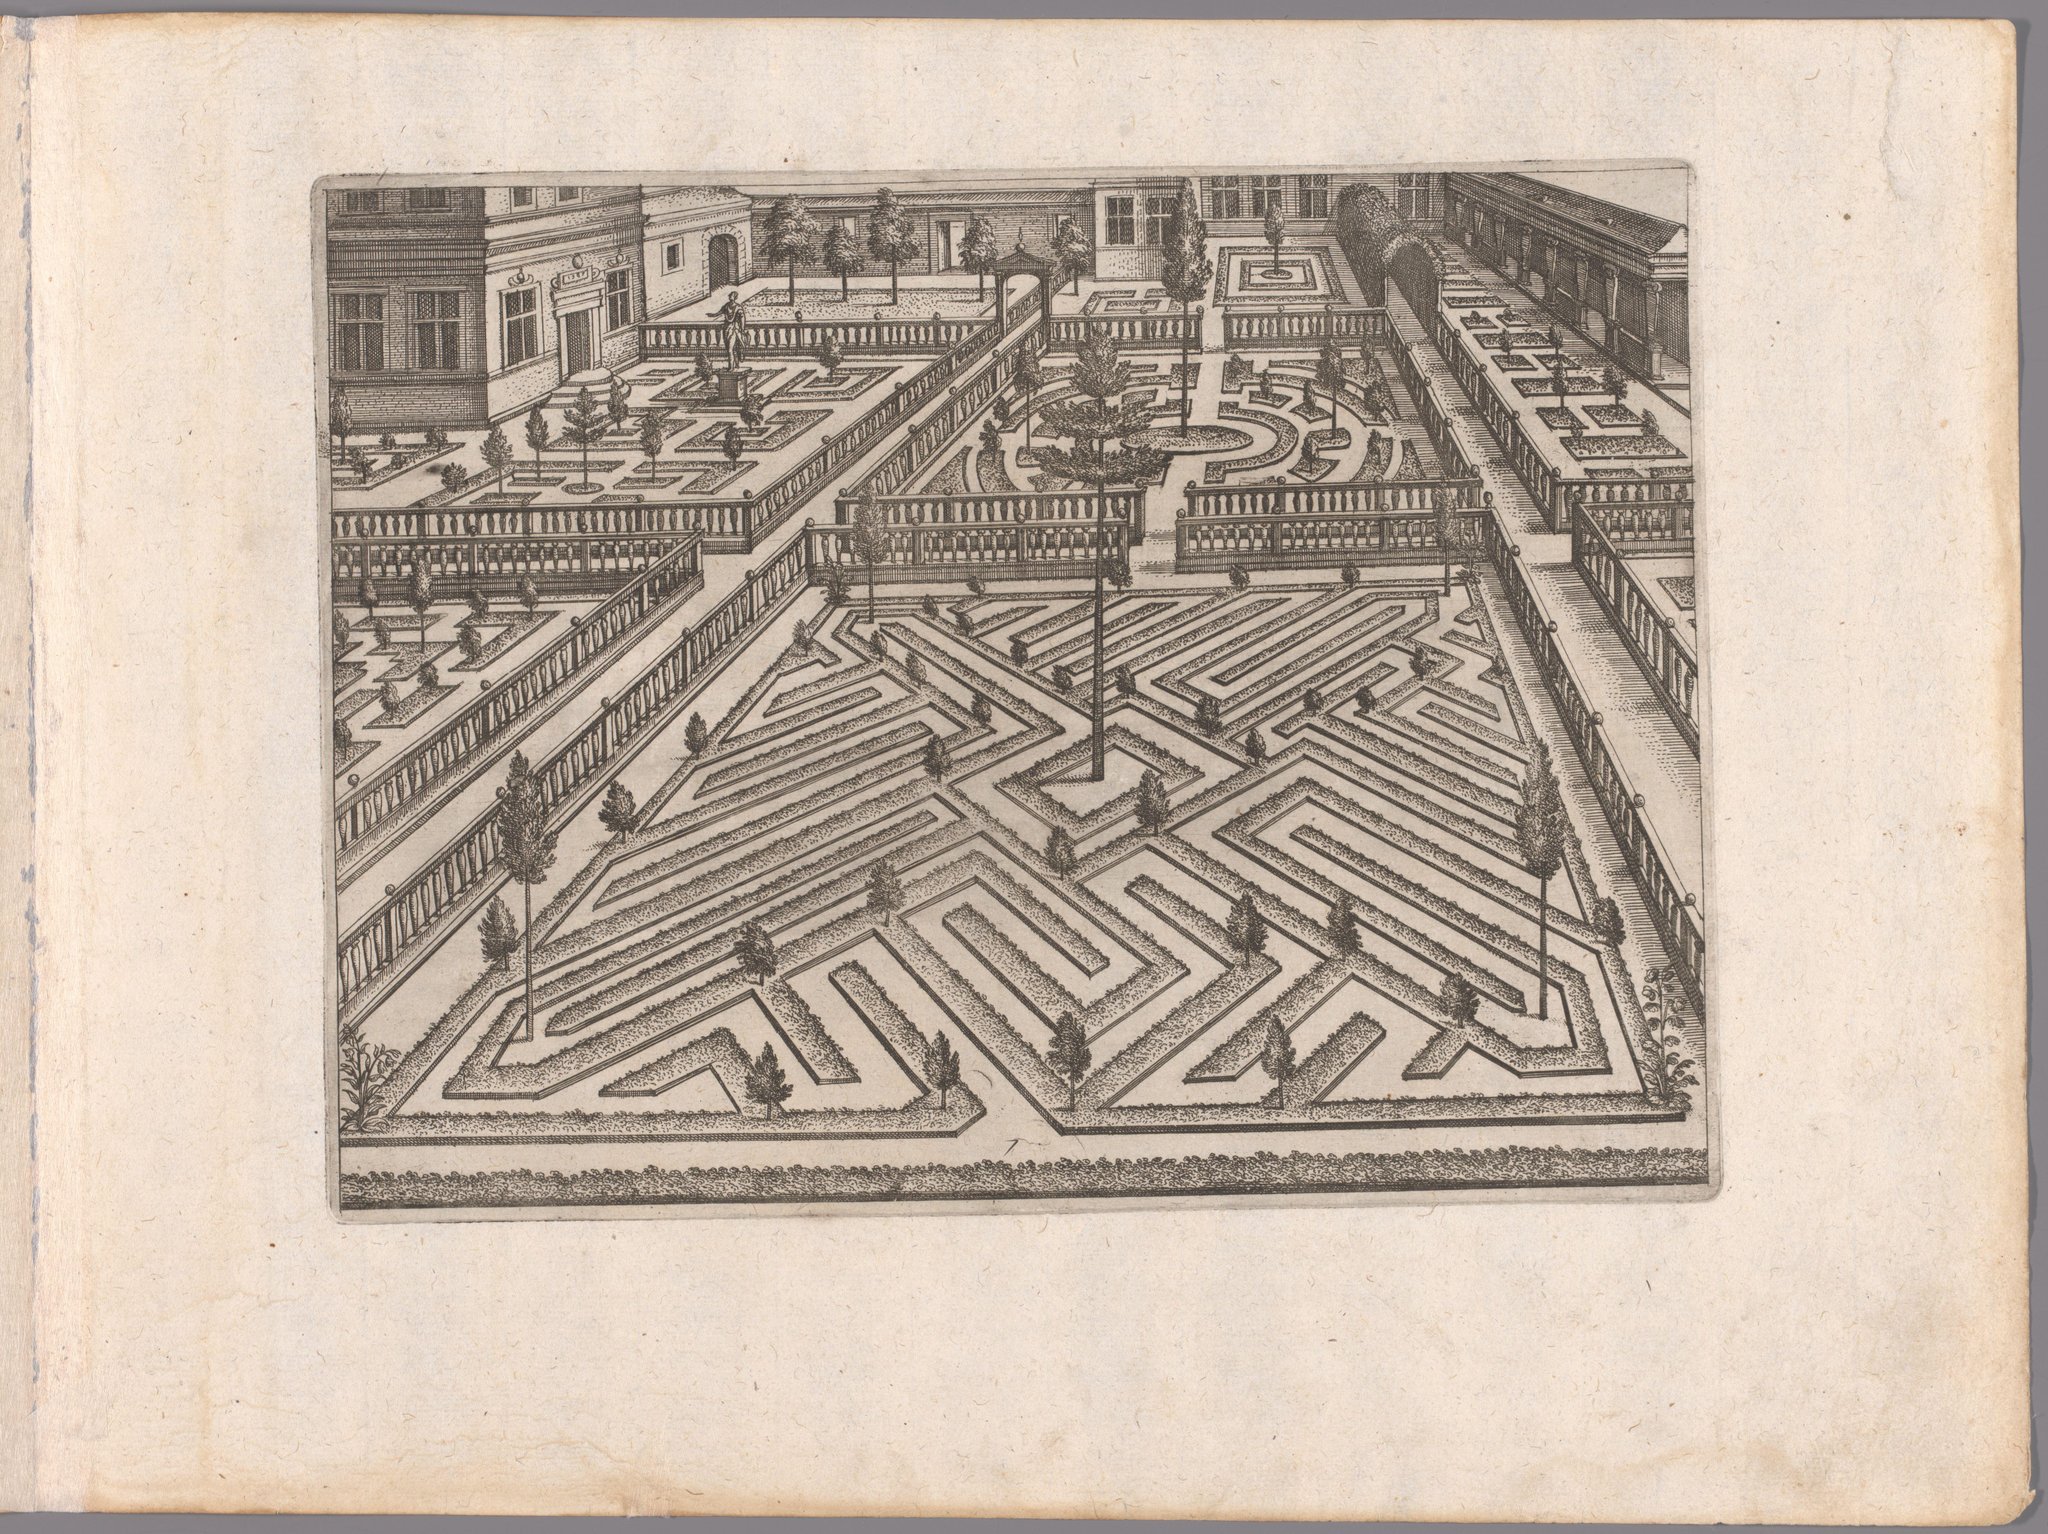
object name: ornament print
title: Tuinen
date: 1587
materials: paper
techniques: etching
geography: antwerp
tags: garden, labyrinth, maze ~ garden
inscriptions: collector's mark: Lugt 2228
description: Tuin met diverse parterres, omgeven door balustrades. Op de voorgrond staat een hoge boom in het midden. In het perk links achter staat een beeld op een sokkel.